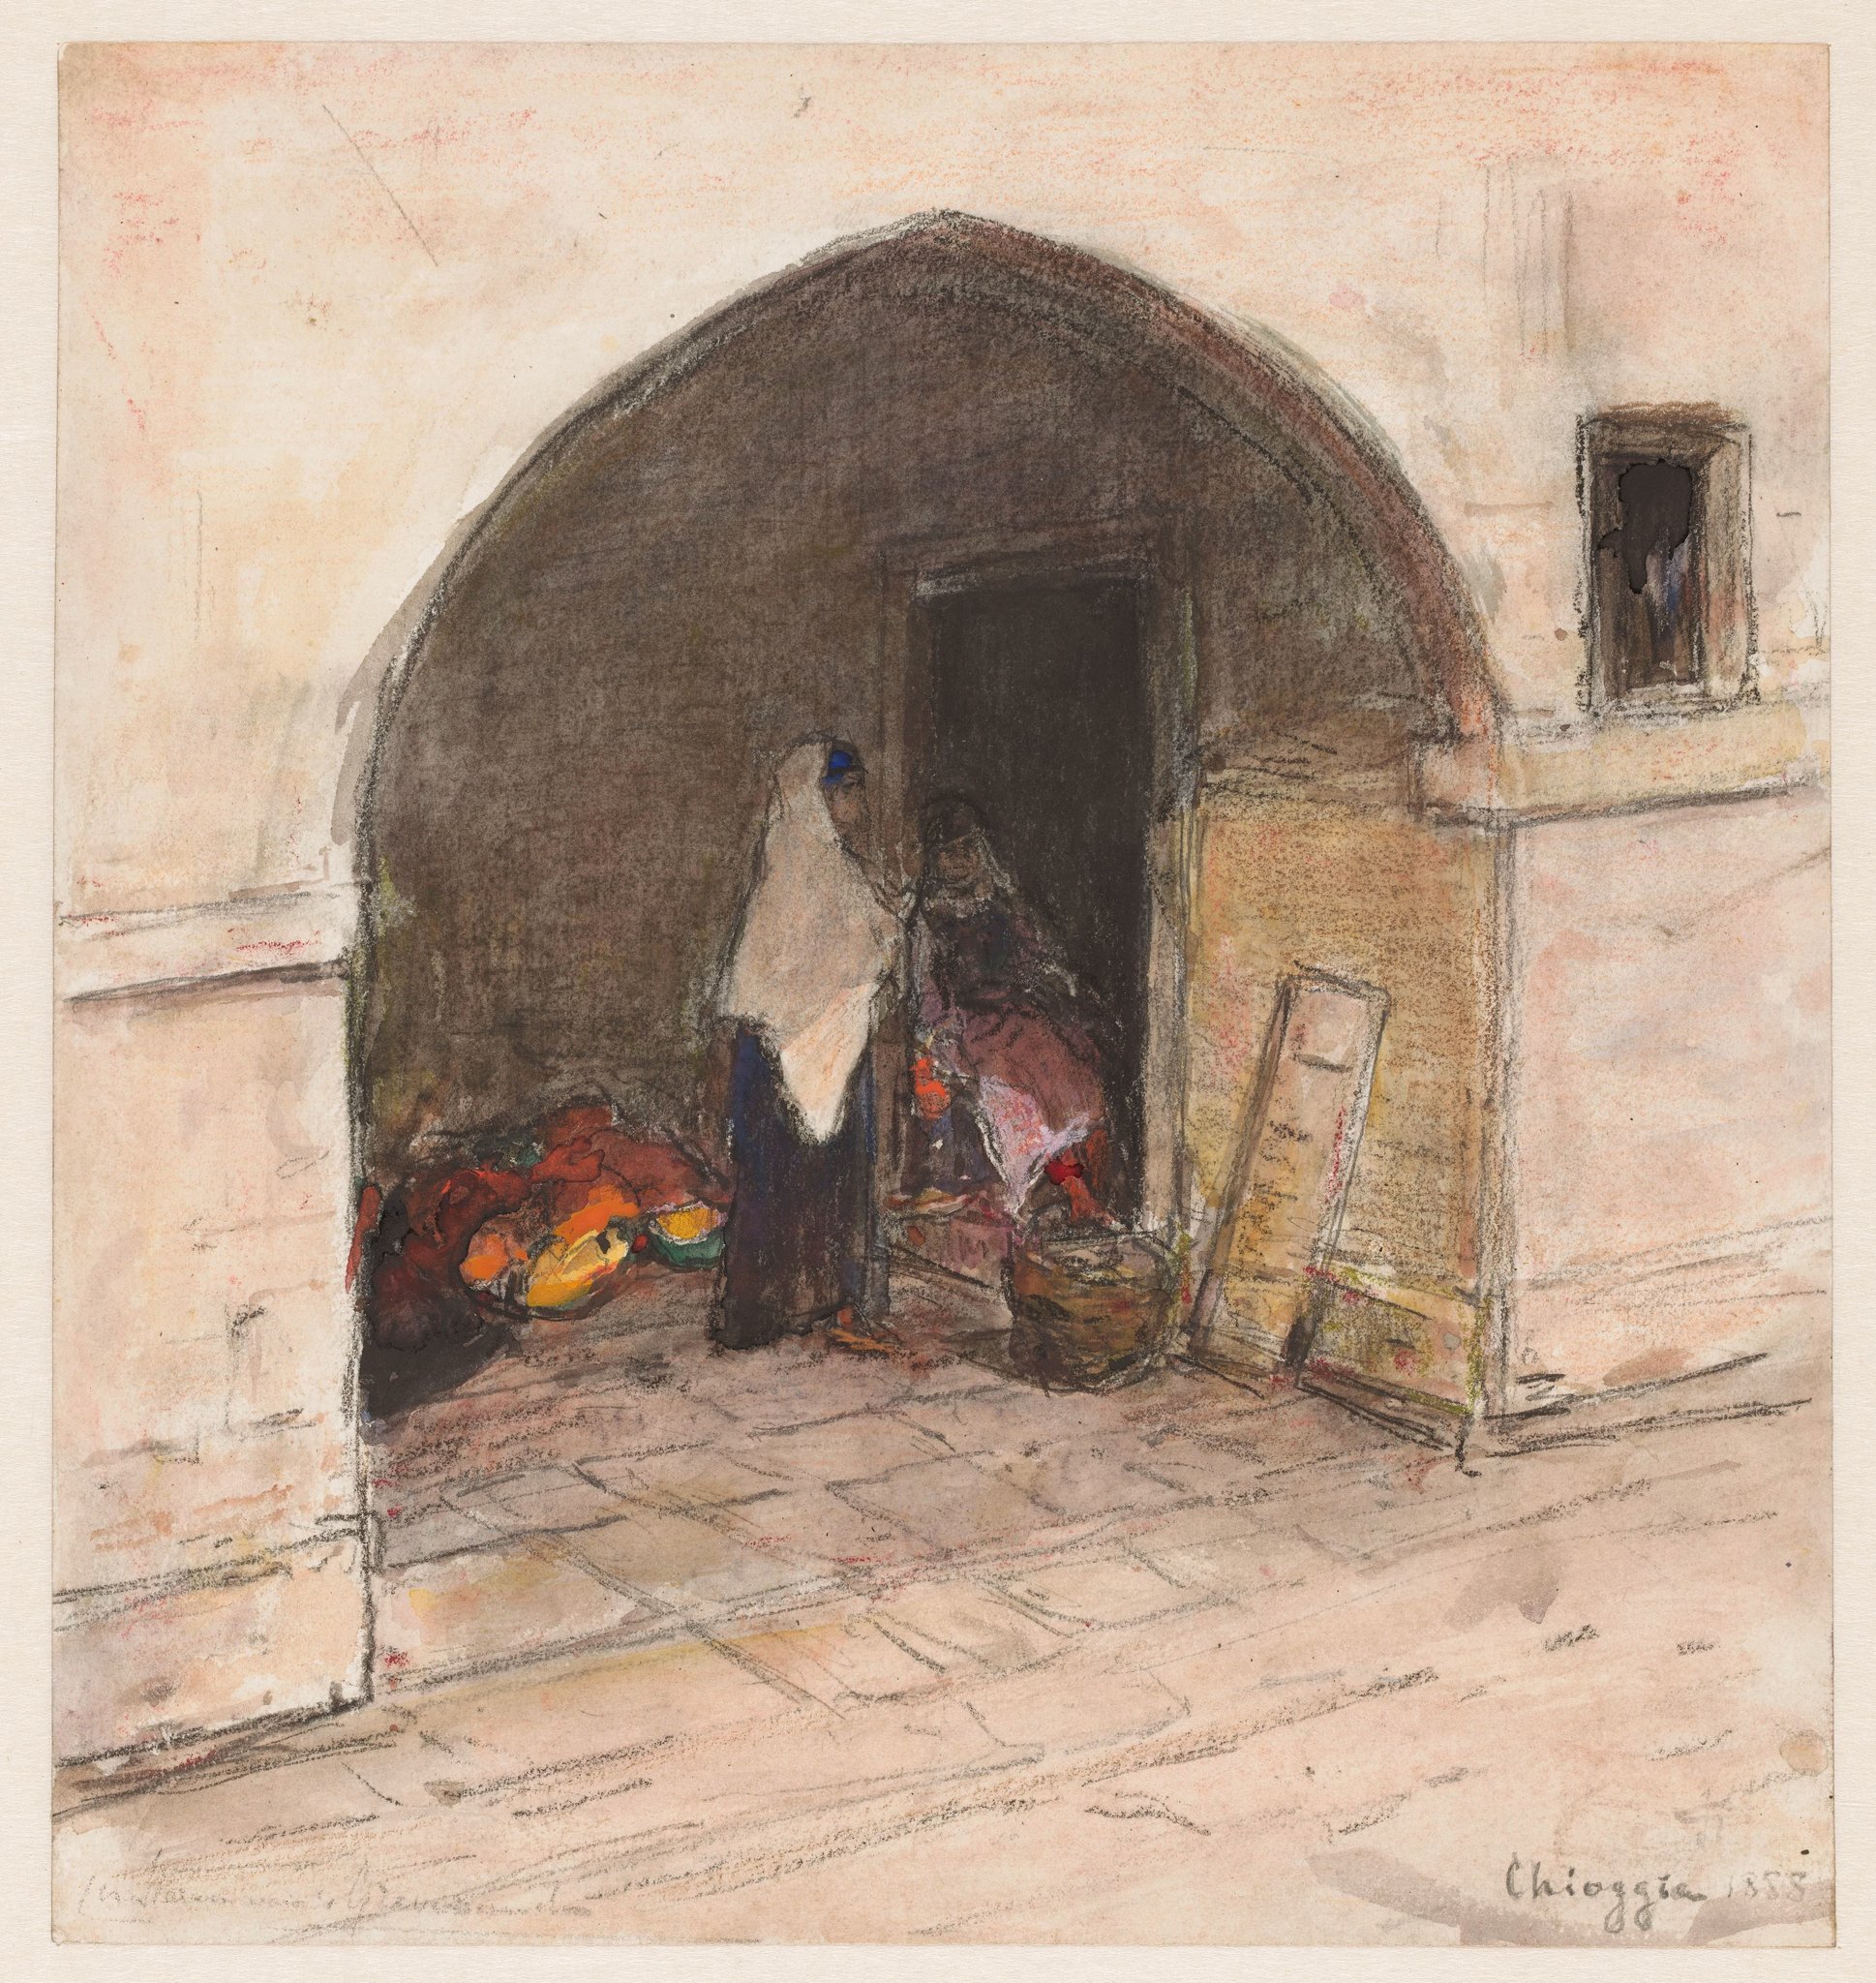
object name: drawing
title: Straattafereel met oosters geklede vrouwen te Chioggia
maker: carel nicolaas storm van s-gravesande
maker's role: draughtsman, print maker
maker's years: 1841-1924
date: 1888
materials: chalk, paper, pencil, watercolor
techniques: brush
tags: city-view, and landscape with man-made constructions